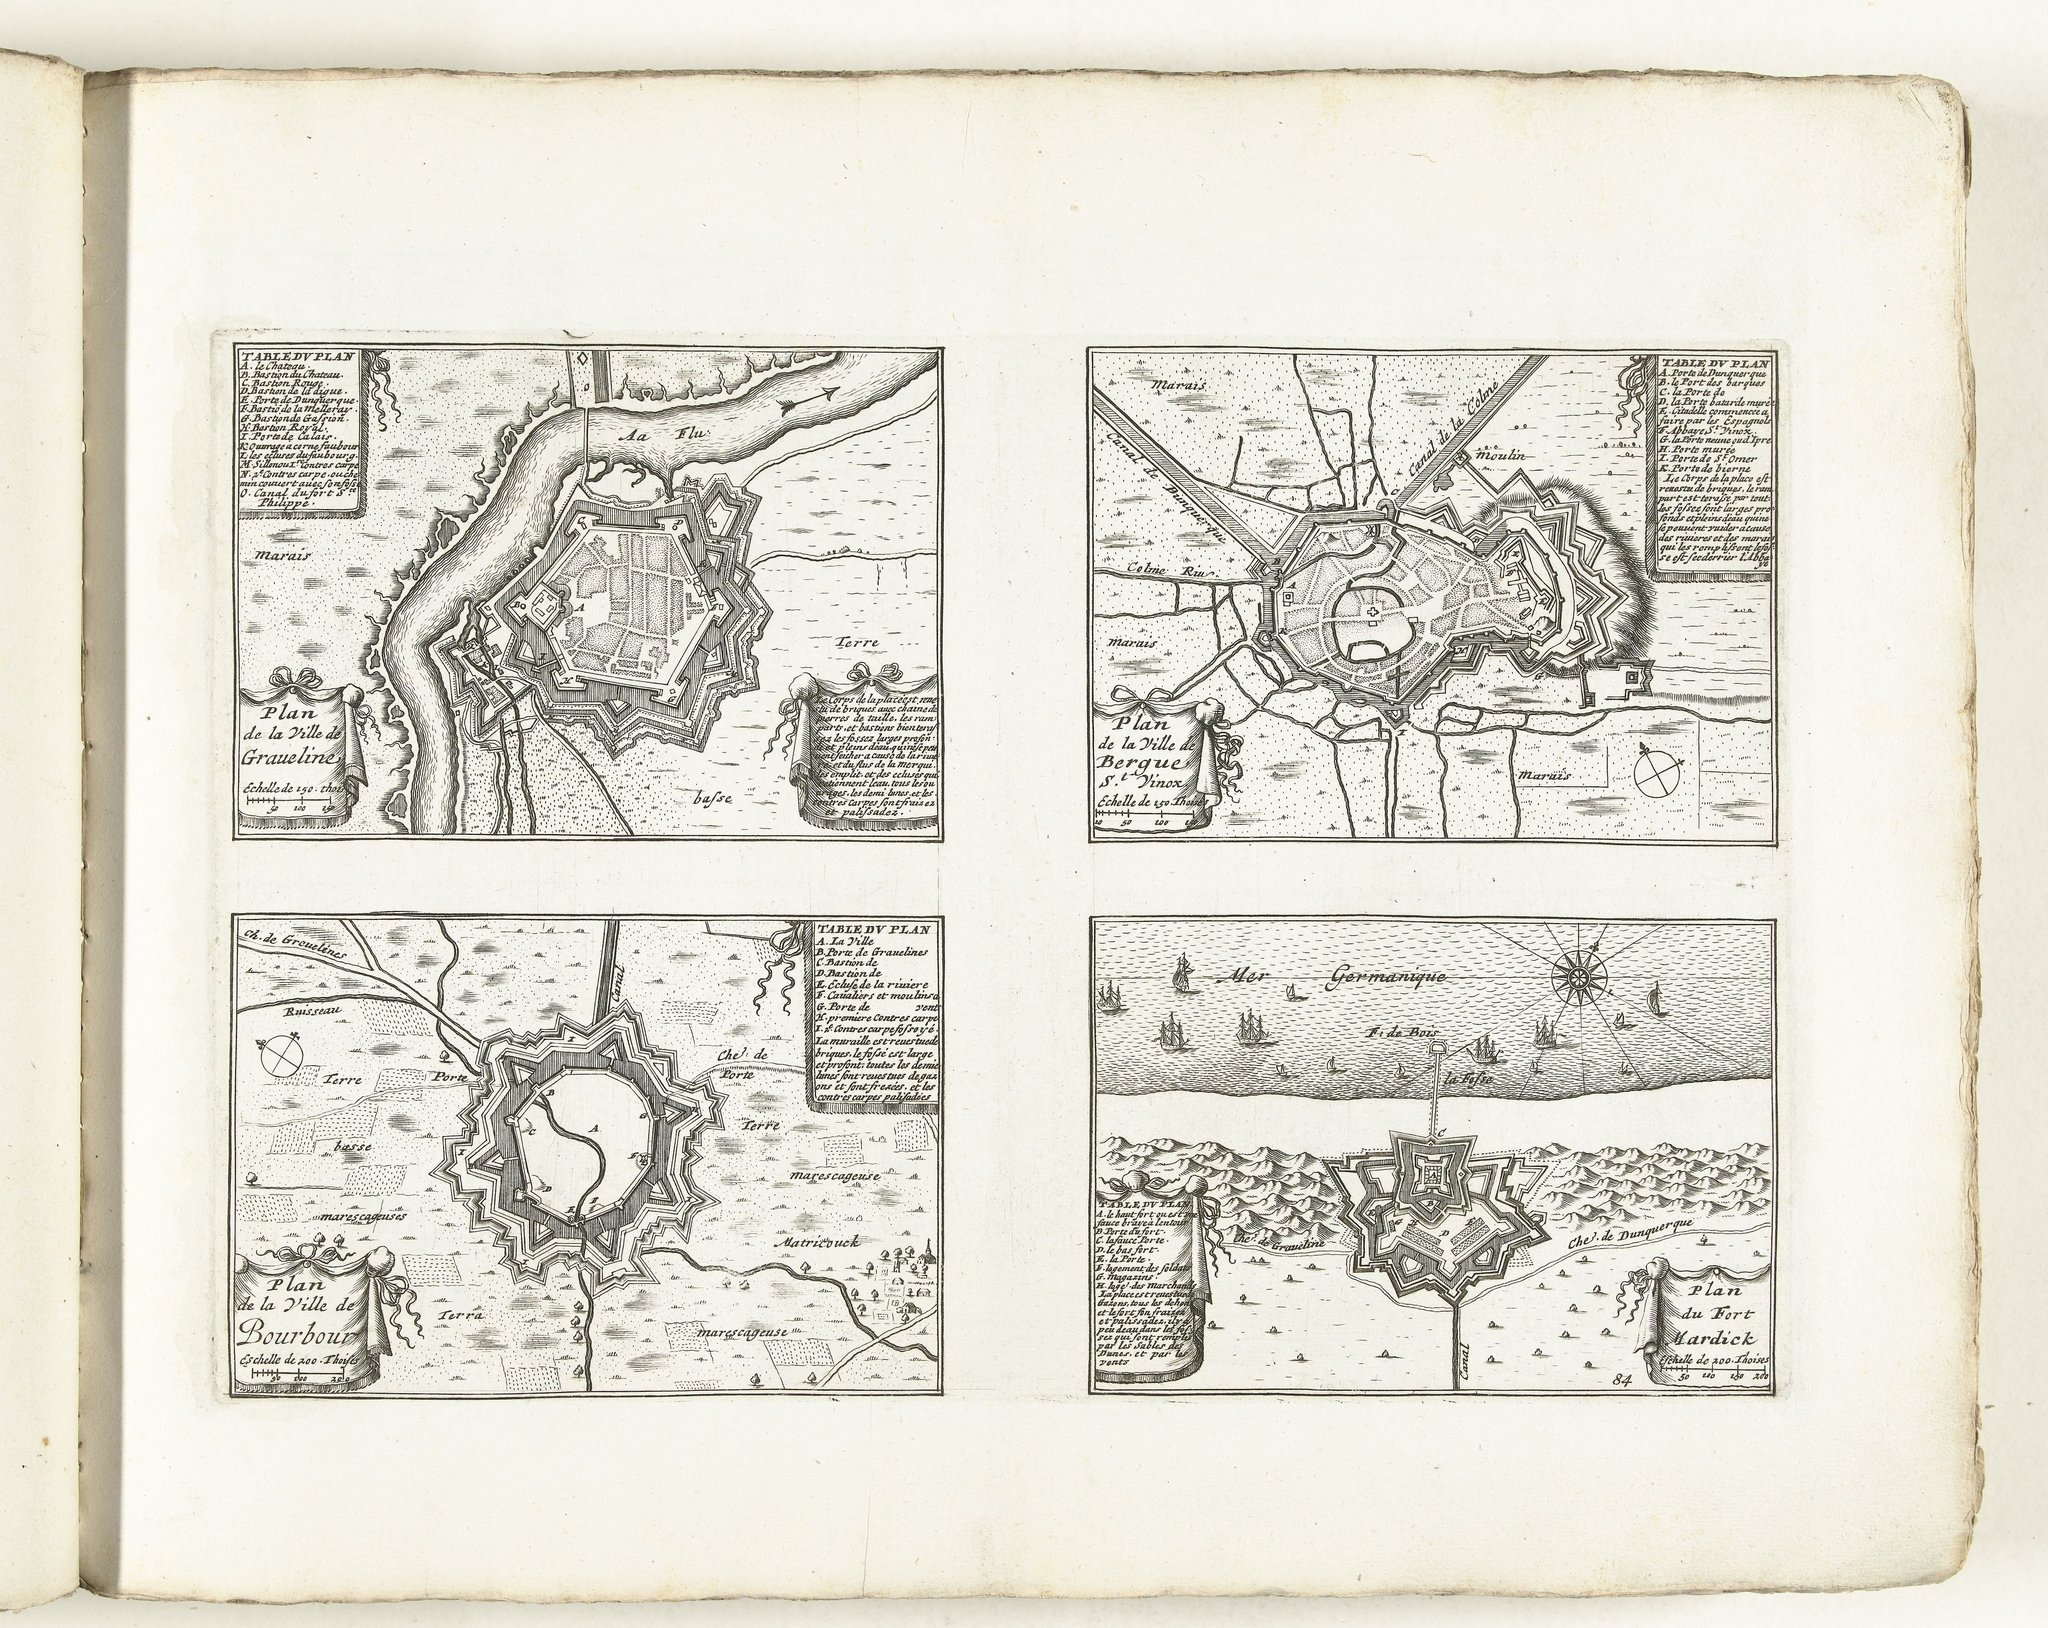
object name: print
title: Plattegronden van Gravelines, Bergues, Bourbourg en Mardijk, ca. 1702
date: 1702-1703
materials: paper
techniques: engraving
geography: northern netherlands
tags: fortress, maps of cities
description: Blad met vier plattegronden van de versterkingen om de steden Gravelines (Grevelingen), Bergues (Sint-Winoksbergen), Bourbourg en Mardijk. Plaat nr. 84 in het prentwerk bestaande in totaal uit 276 genummerde platen van vermaarde sterke steden en vestingen in het kader van de Spaanse Successieoorlog. Voor het merendeel zijn deze platen gekopieerd naar de anonieme Franse platen: in Les forces de l'Europe en in: Le theatre de la guerre, dans les Pays-Bas, beide oorspronkelijk uitgegeven door Nicolas de Fer te Parijs (1693-1697) in het kader van de Negenjarige Oorlog. Titels en opschriften in de plaat in het Frans.